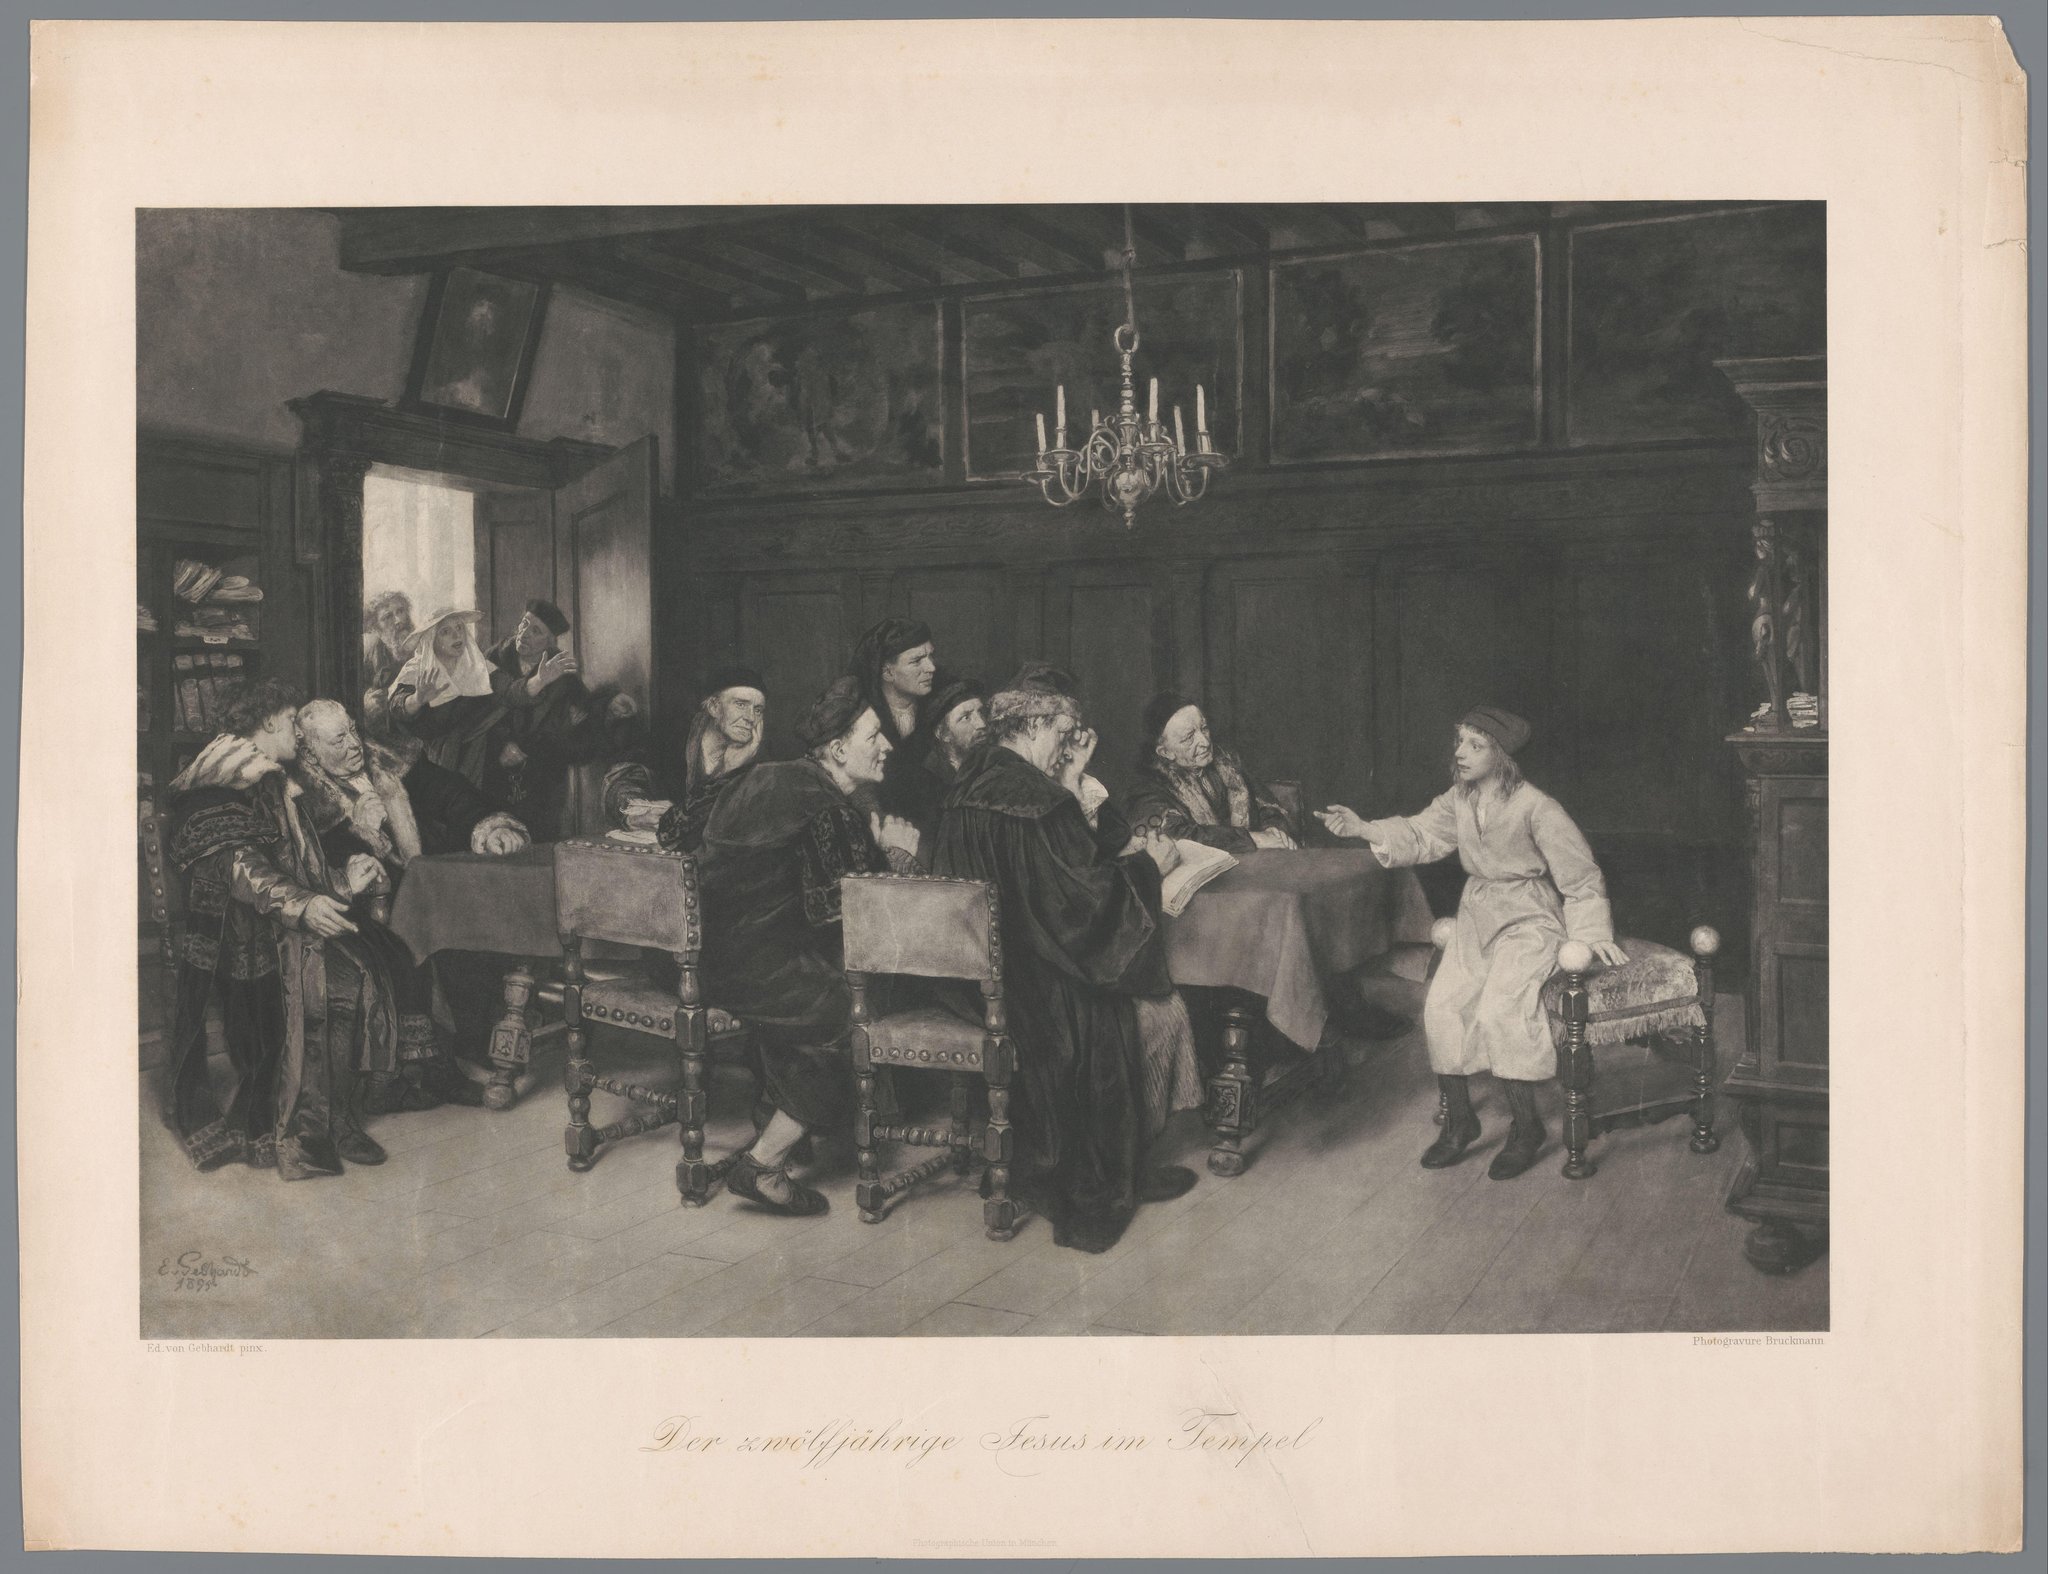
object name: photograph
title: Fotoreproductie van schilderij Der zwölfjährige Jesus im Tempel [De twaalfjarige Jezus in de tempel] door Ed. von Gebhardt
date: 1875-1889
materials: cardboard, paper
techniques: photoaquatint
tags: picture, painting